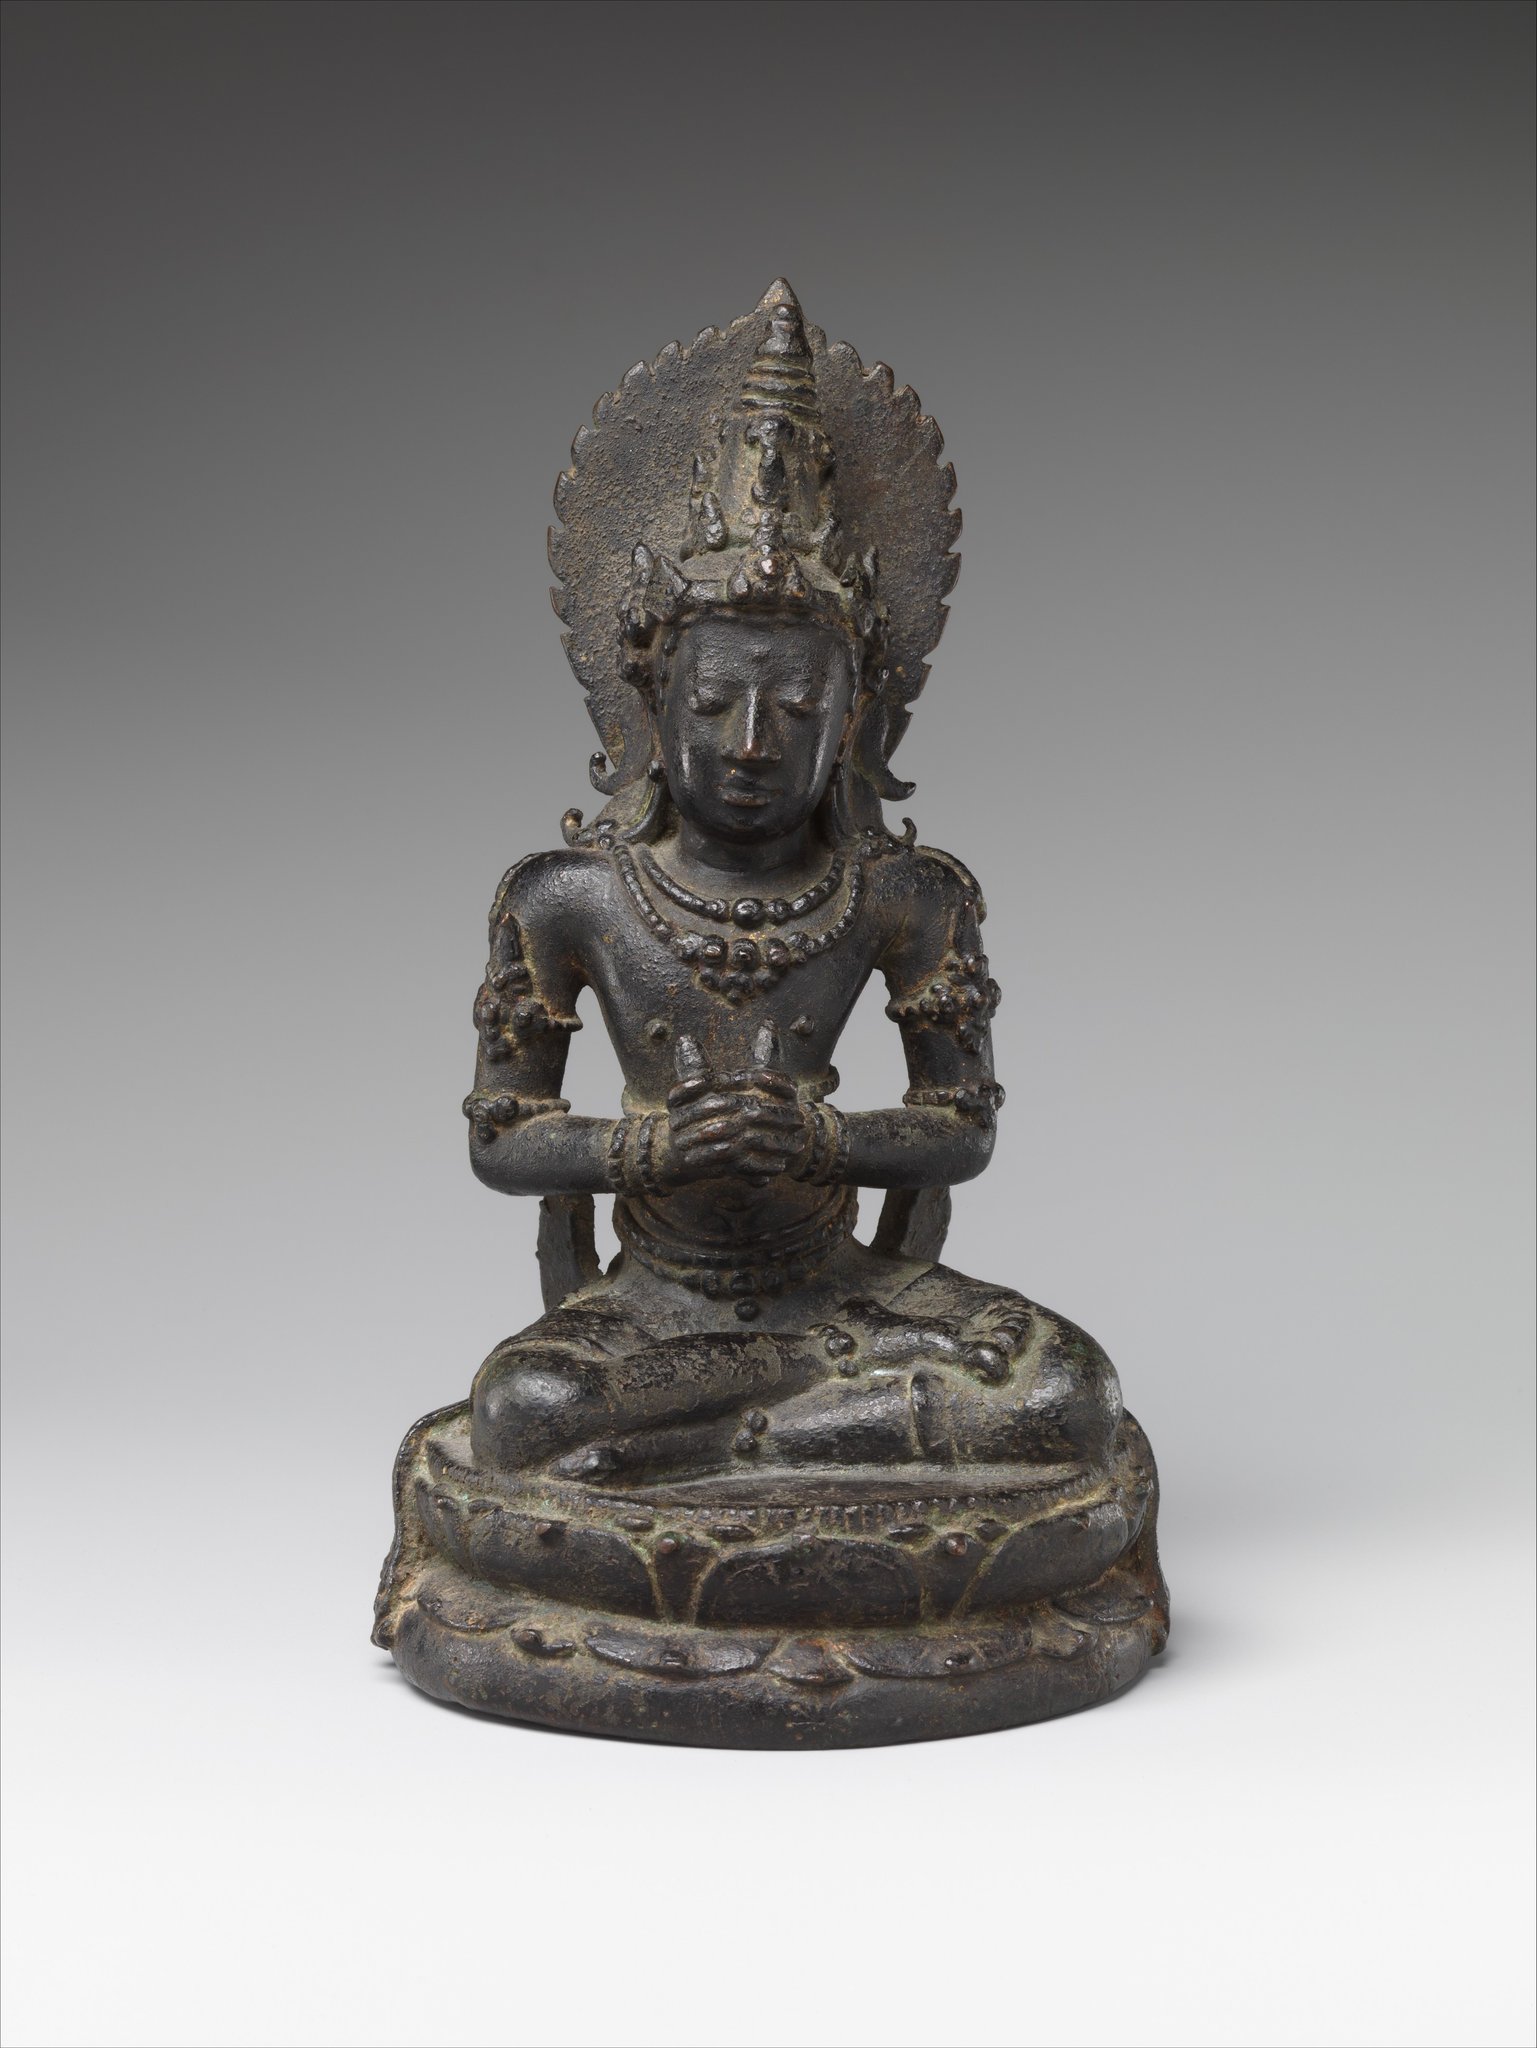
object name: figure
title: Seated Esoteric Buddhist Deity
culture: indonesian, javanese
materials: bronze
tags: buddhism,deities